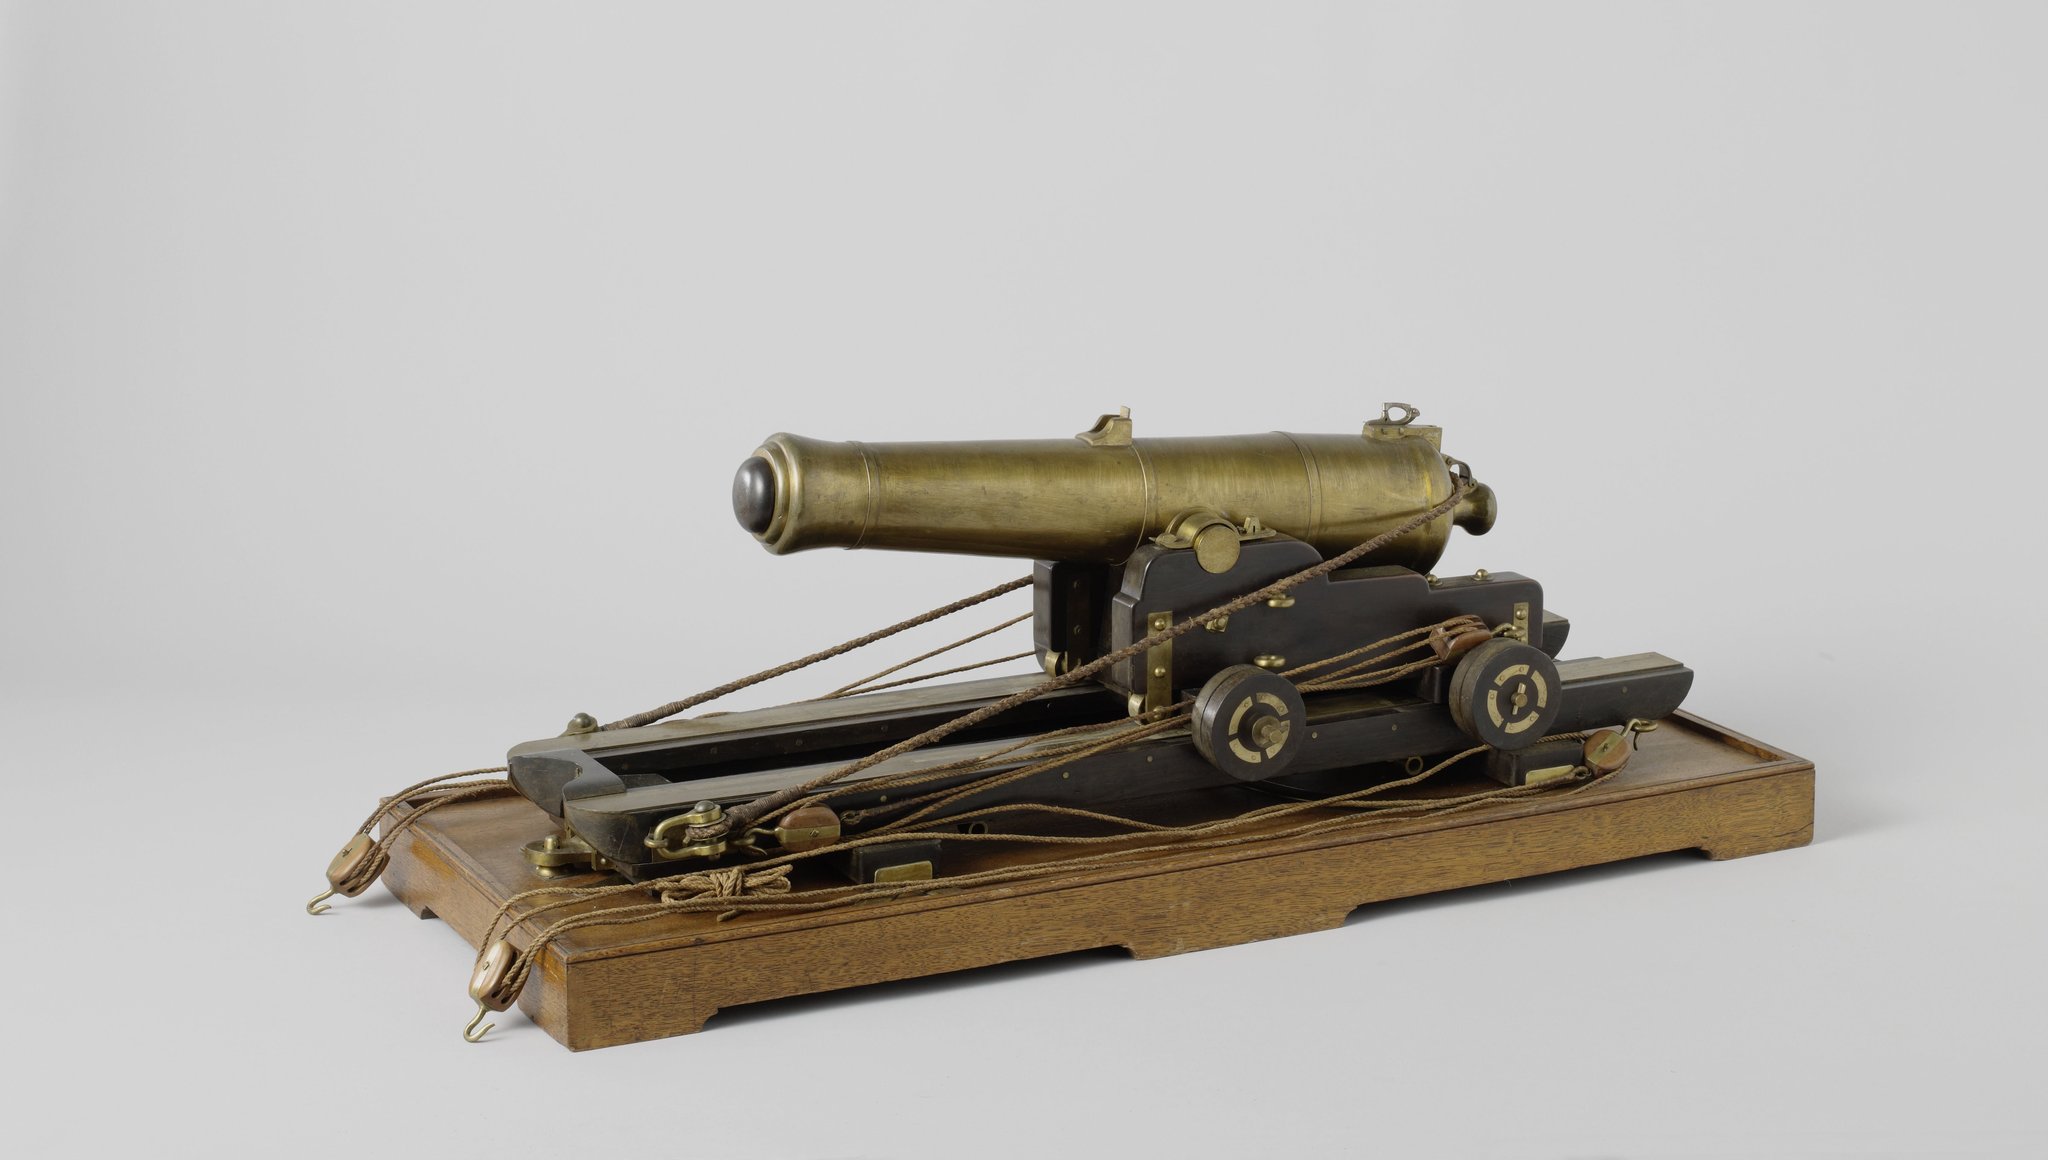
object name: demonstration model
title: Model of a 20-cm Shell Gun on Slide and Pivot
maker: Anonymous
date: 1854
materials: brass, iron, fiber, wood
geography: netherlands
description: Granaatkanons werden in Nederland vanaf 1825 gebruikt. De eerste 20 duims granaatkanons waren uitgeboorde 36 ponders (1833). Latere typen werden aangegoten in Luik, de zwaardere in Engeland.